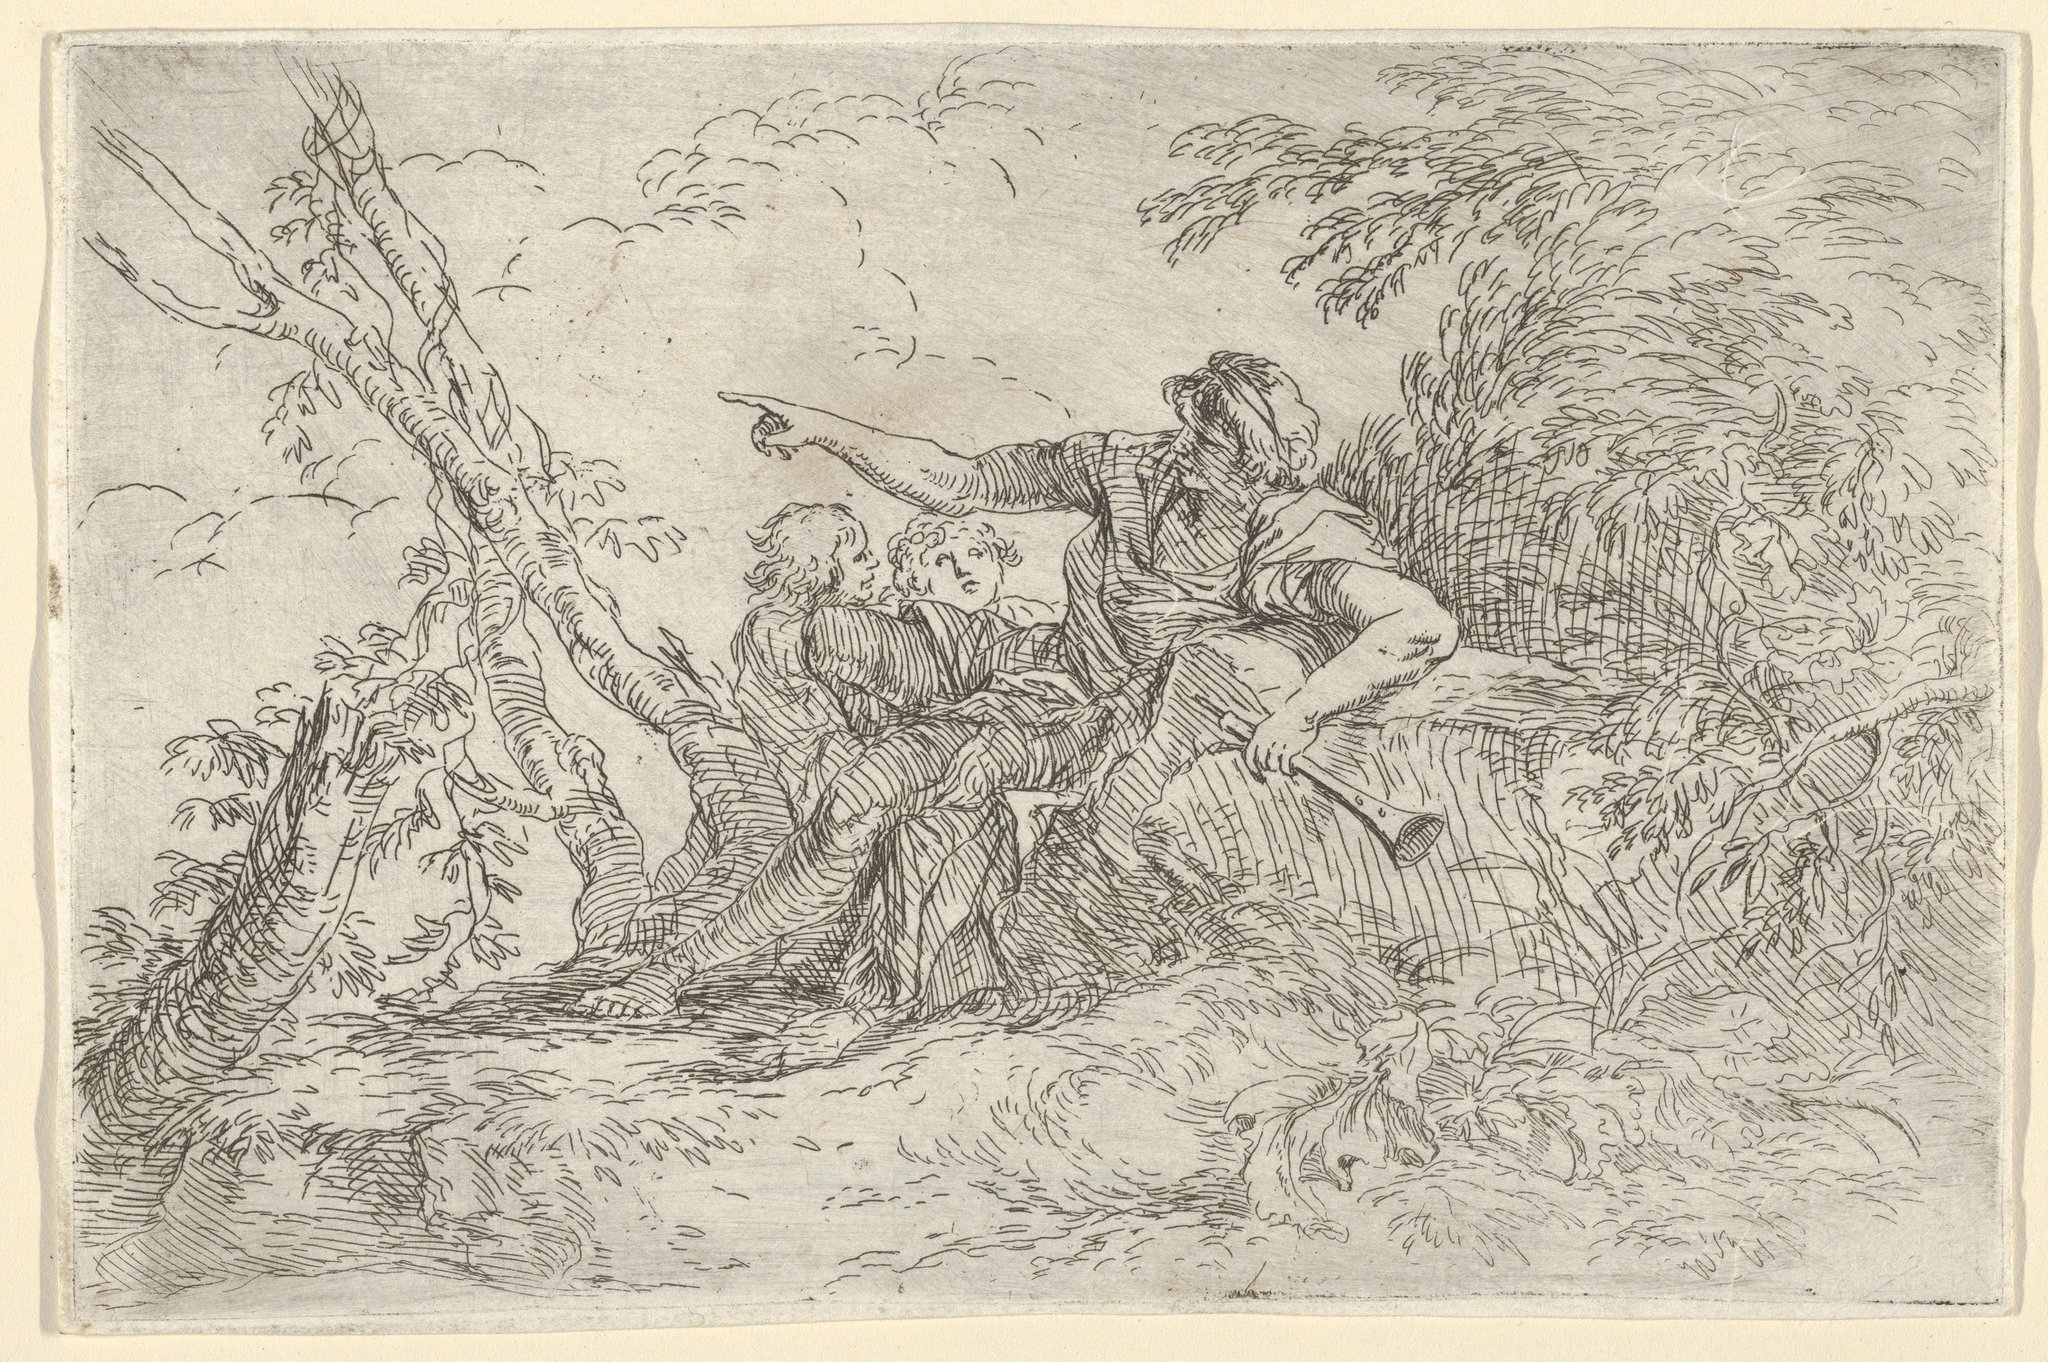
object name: print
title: Shepherd holding a flute and two other figures in a landscape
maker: salvator rosa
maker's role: artist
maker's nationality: italian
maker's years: 1615-1673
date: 1660-1661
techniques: drypoint, etching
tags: men,flutes,trees,shepherds